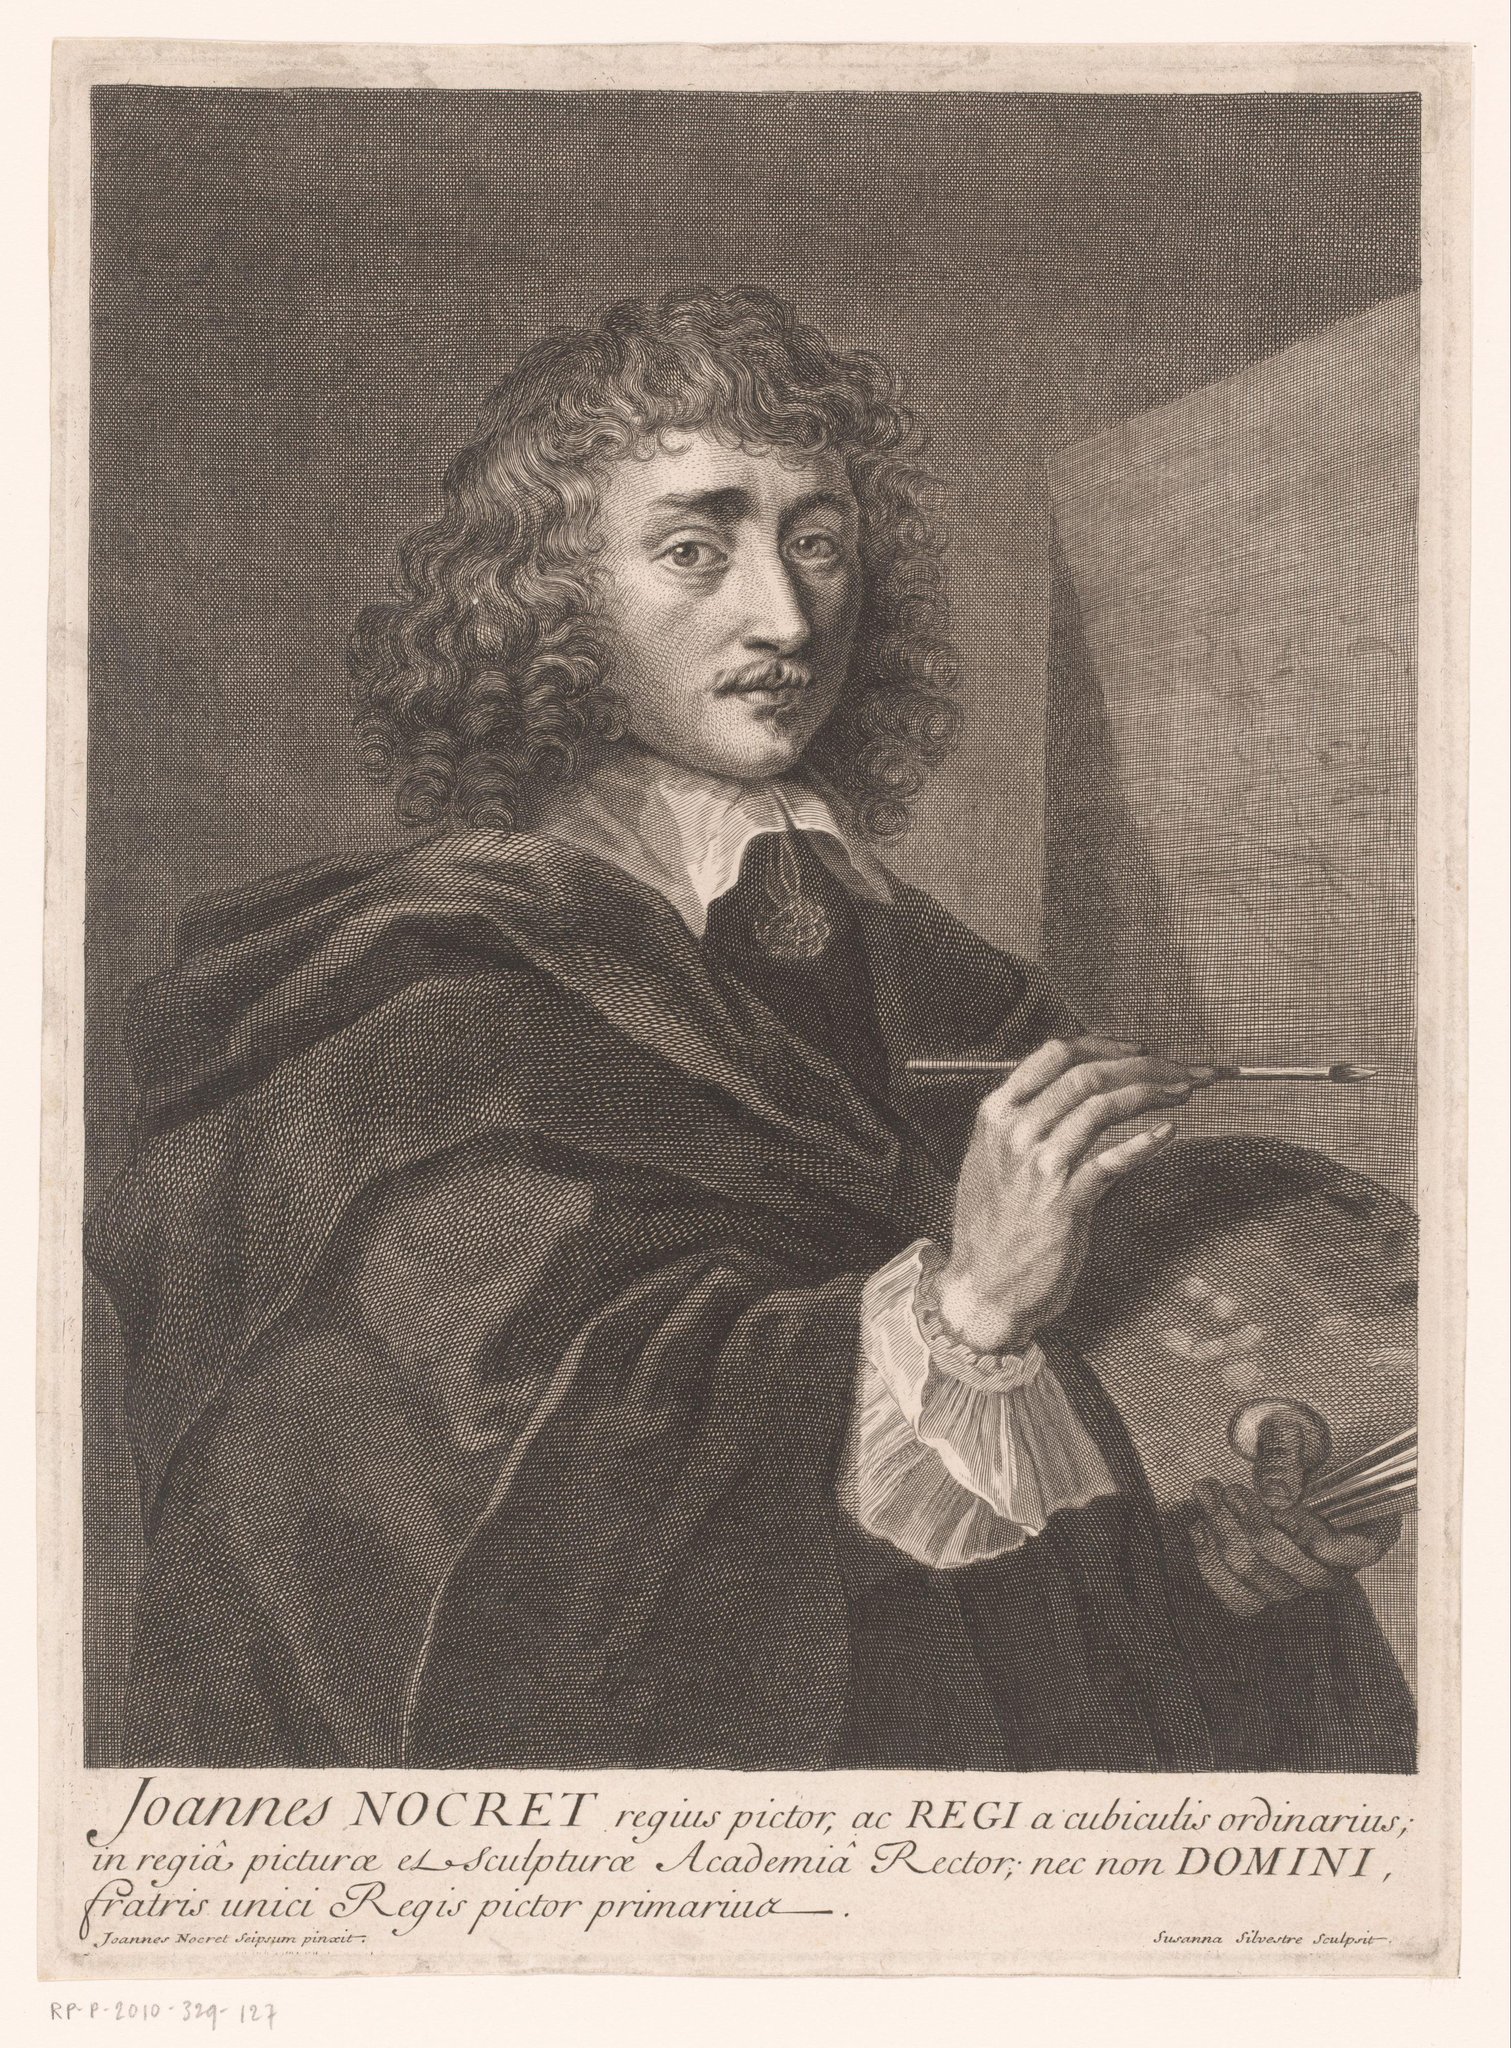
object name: print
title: Portret Jean Nocret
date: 1704-1738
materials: paper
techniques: engraving, etching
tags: painter, jean nocret, historical persons, portrait, self-portrait of painter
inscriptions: collector's mark: Lugt 2228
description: Portret van de schilder Joannes (Jean) Nocret (1615-1672), ten halven lijve, met palet en penseel in de hand, staand voor zijn ezel. Naar een geschilderd zelfportret. Met onderschrift in Latijn.